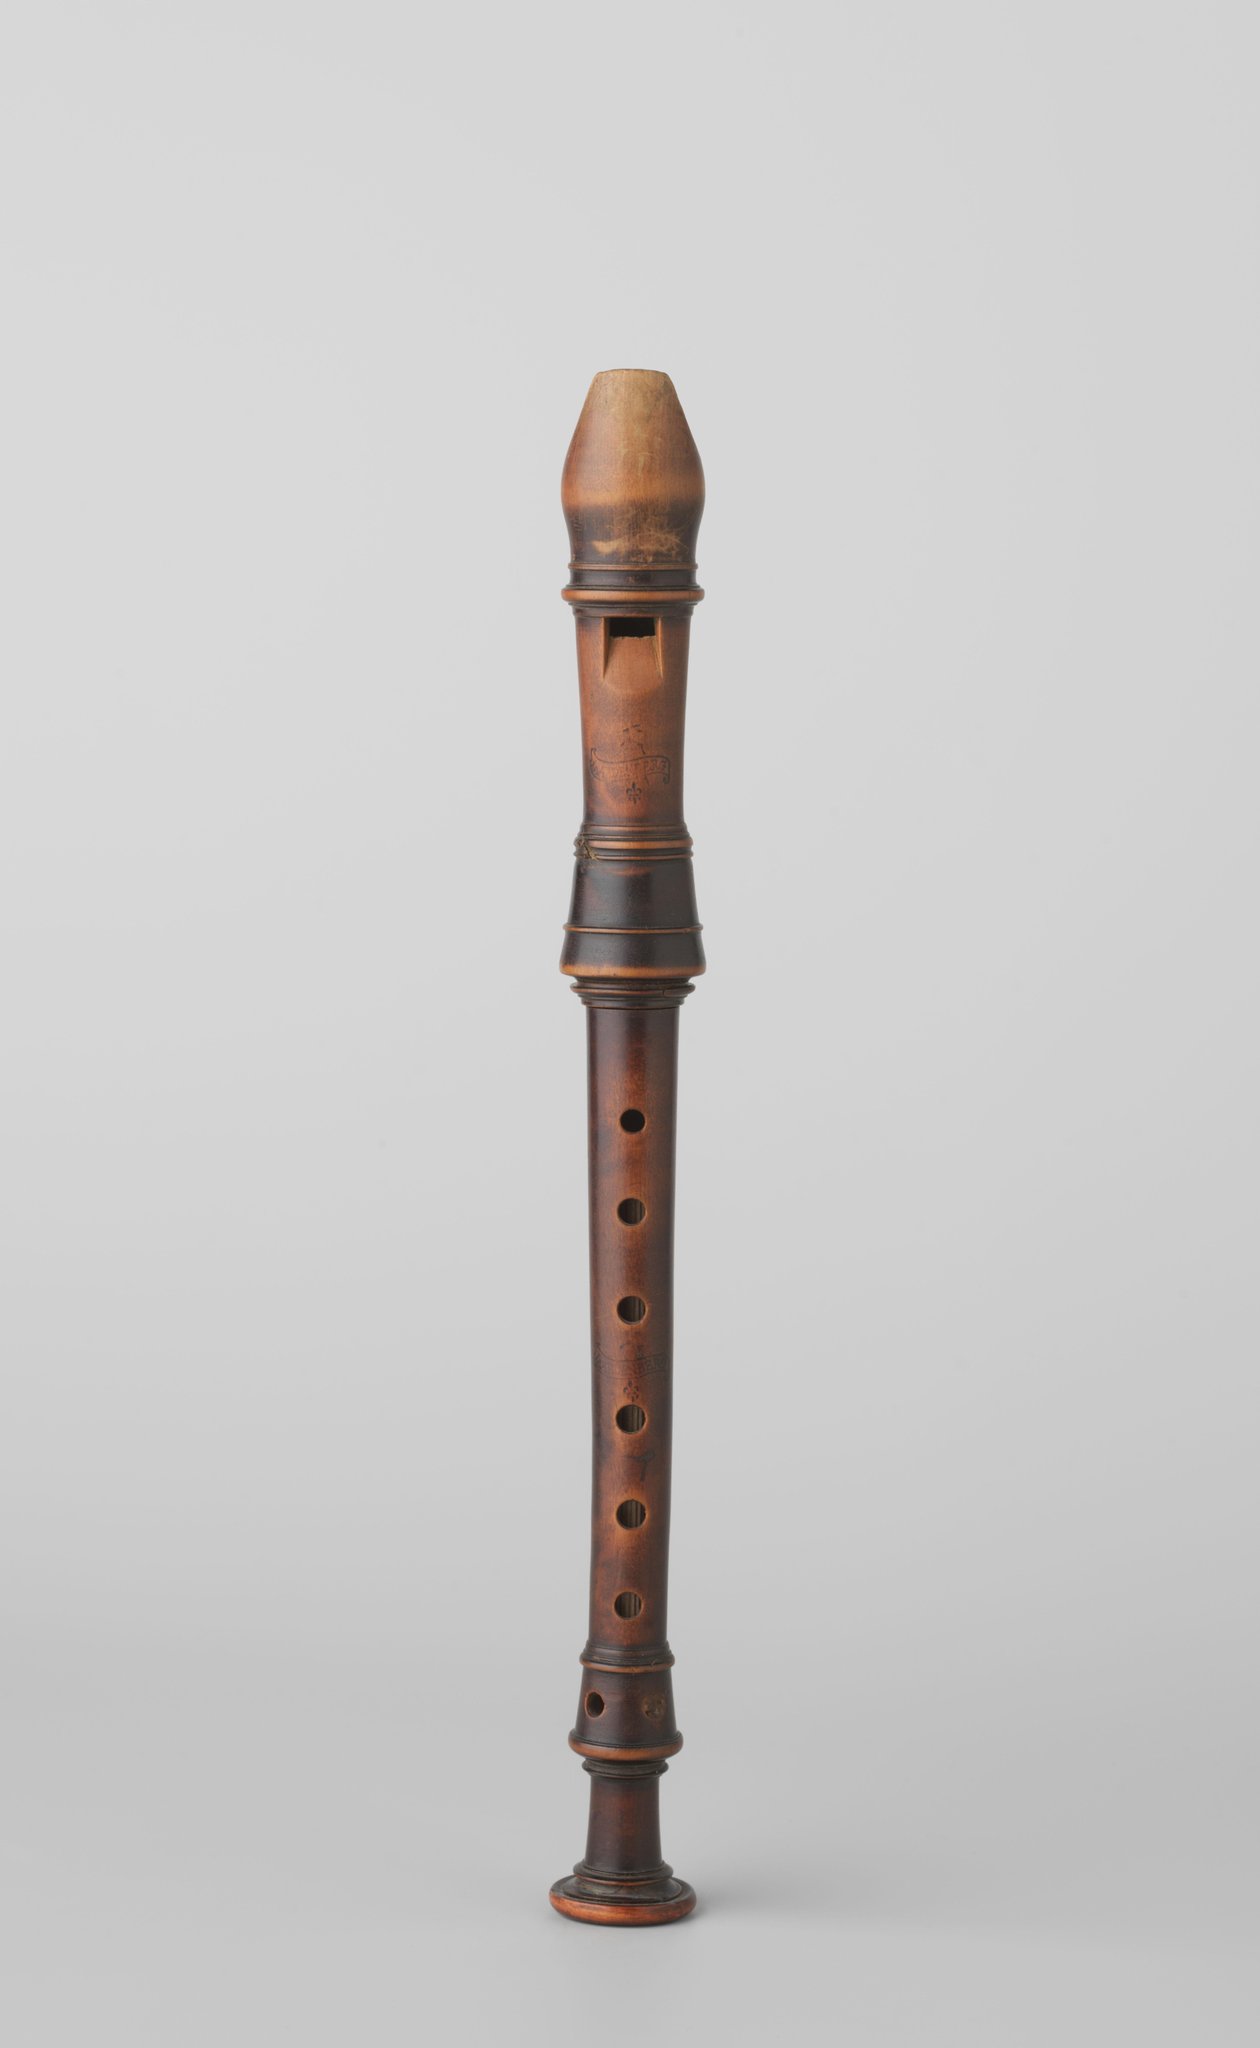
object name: recorder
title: Sopranino Recorder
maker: abraham van aardenberg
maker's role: musical instrument maker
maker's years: 1672-1717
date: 1698-1717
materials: wood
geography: amsterdam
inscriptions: stamp: ‘[springend hert] AARDENBERG [in een banderol] / [fleur de lis]’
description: Tweedelige sopraninoblokfluit in e (bij een stemming van a-415 Hz) of f (bij een lagere stemming), gemaakt in de karakteristieke stijl van Van Aardenberg. Afgezien van lichte schade (onregelmatige rand) aan het labium en een gerestaureerde beschadiging (uitgebroken hout) aan de onderste voetring is het instrument gaaf bewaard gebleven en is nog goed speelbaar.